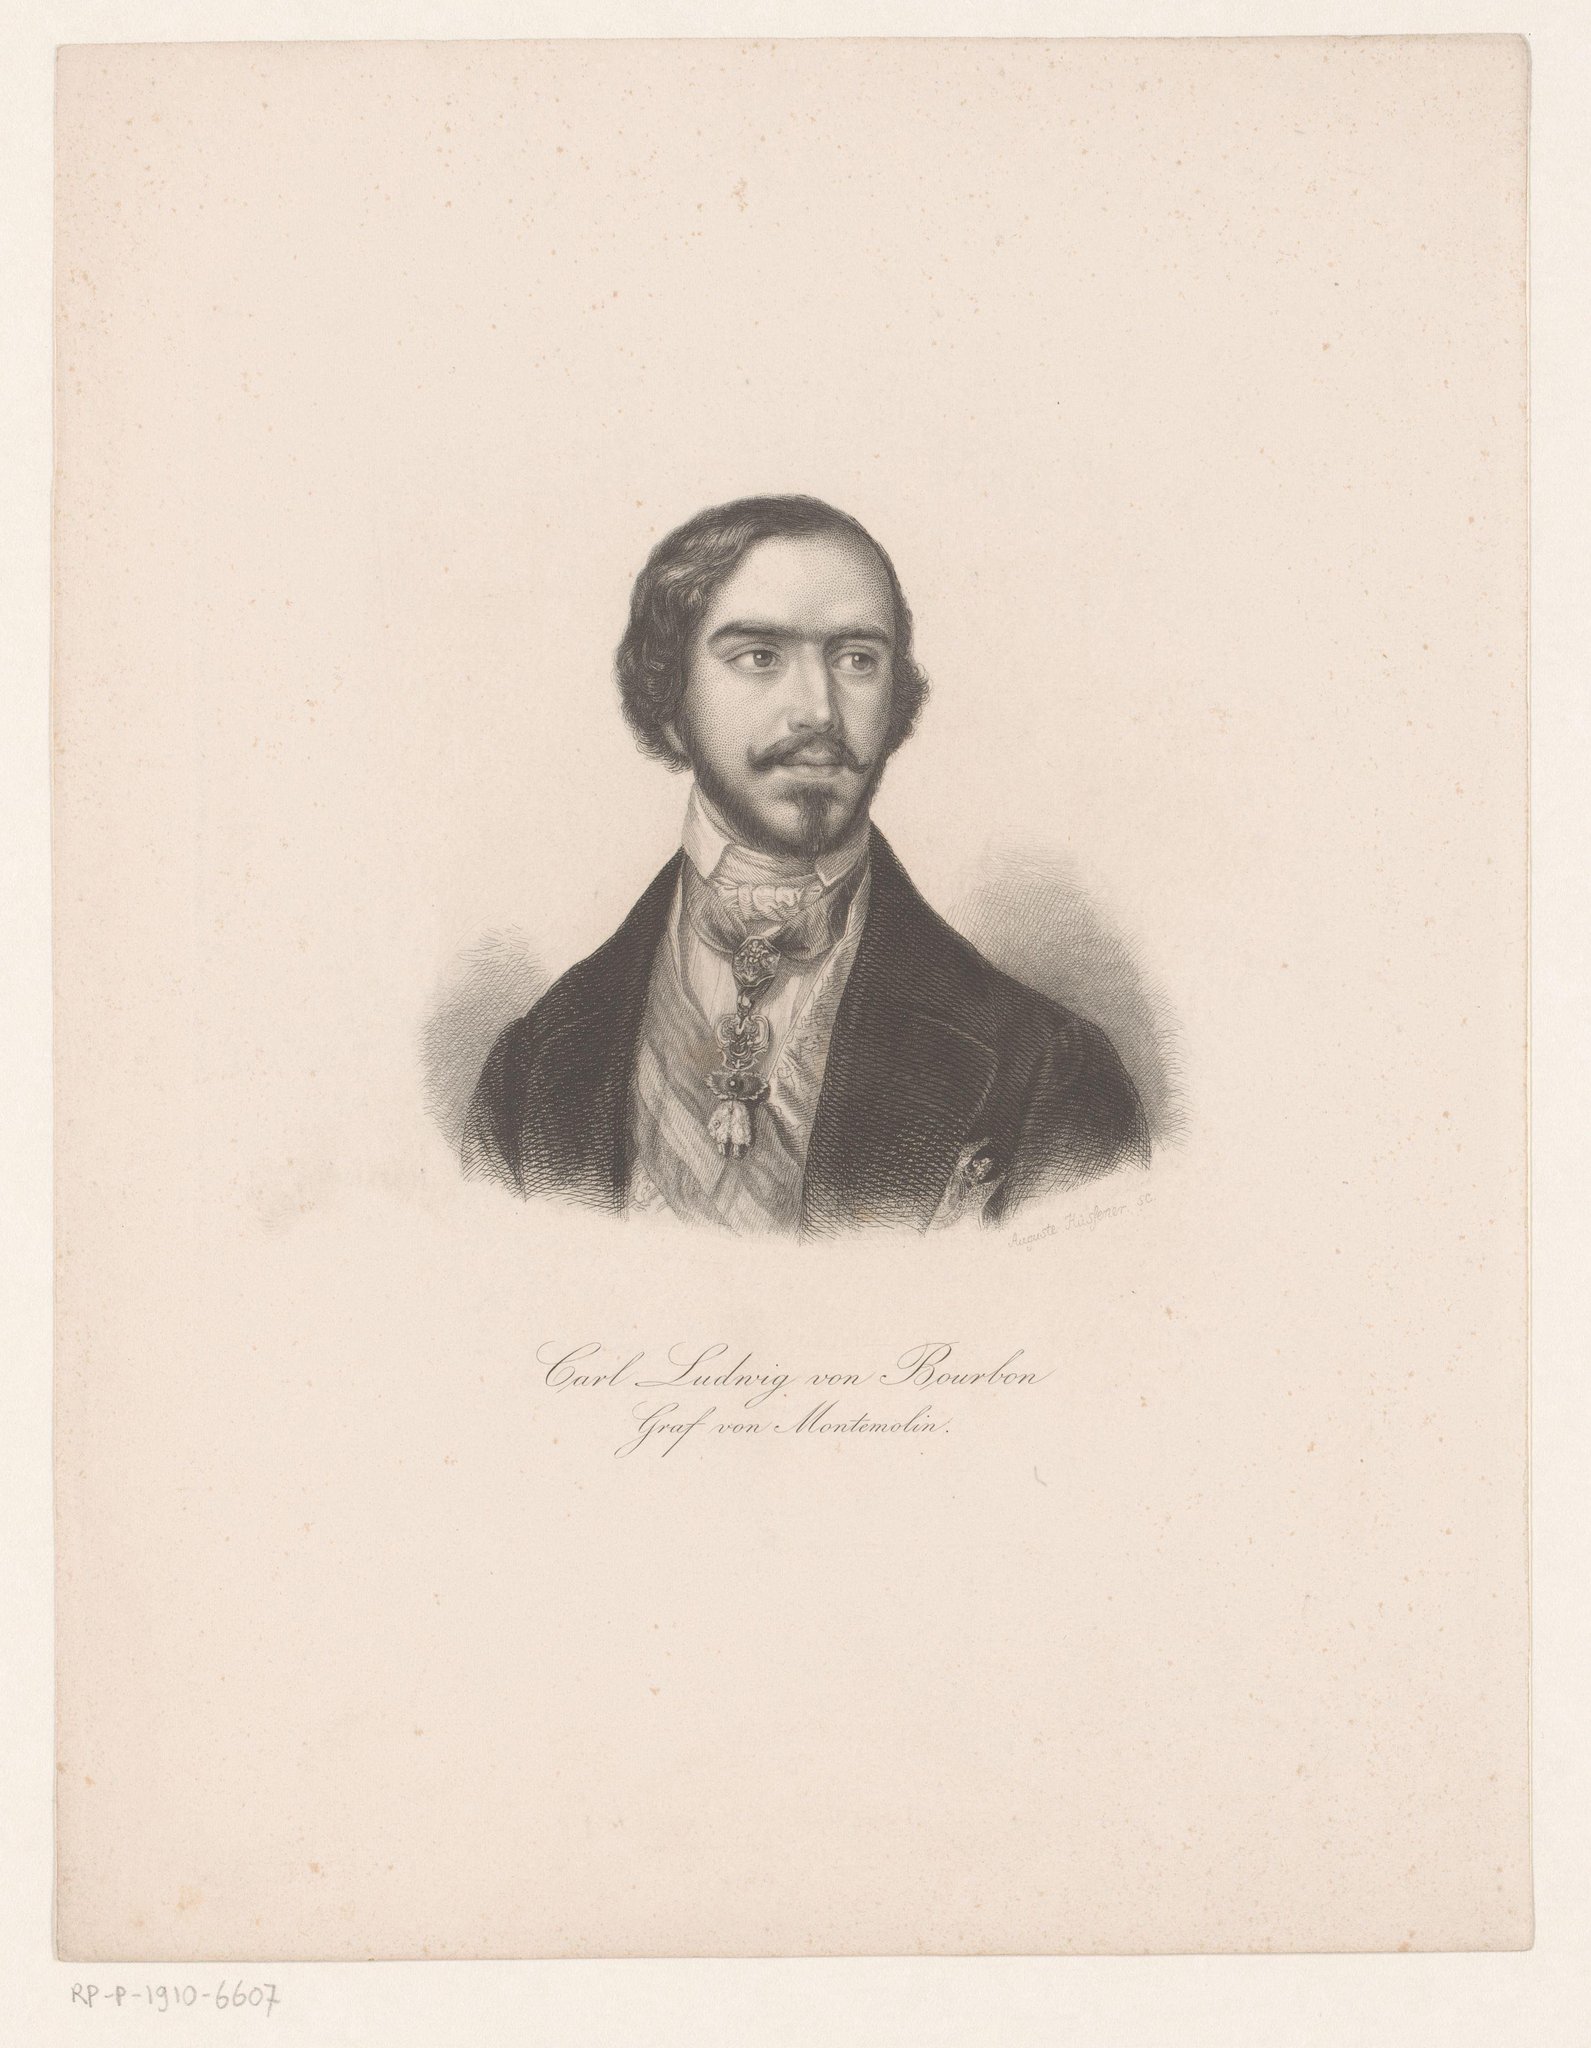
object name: print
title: Portret van Carl Ludwig von Bourbon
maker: auguste hüssener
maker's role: print maker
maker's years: 1789-1877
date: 1799-1877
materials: paper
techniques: etching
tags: earl, commander-in-chief, general, marshal, historical persons, pendant, trinket, 'breloque'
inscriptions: collector's mark: Lugt 2228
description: De graaf staat ook bekend als Infante Carlos van Spanje.